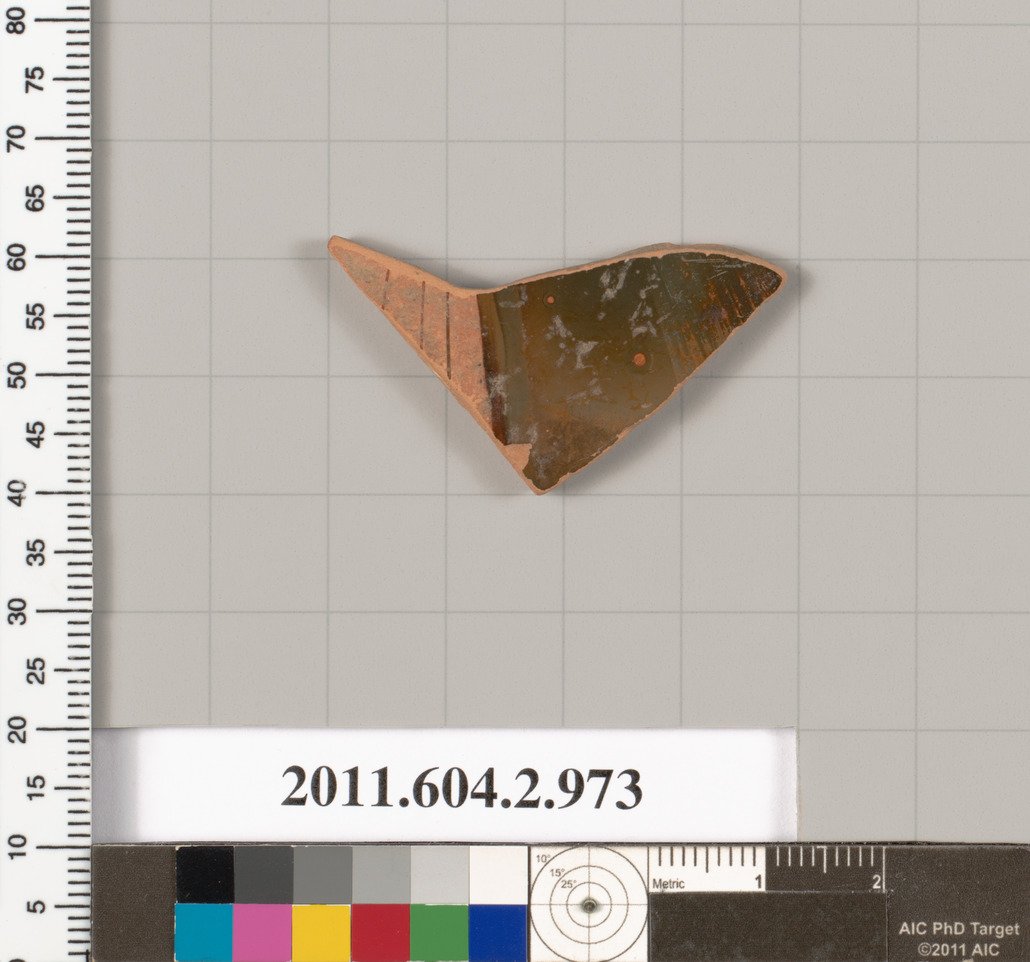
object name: oinochoe fragment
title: Terracotta fragment of an oinochoe (jug)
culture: greek, attic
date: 475-451 BCE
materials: terracotta